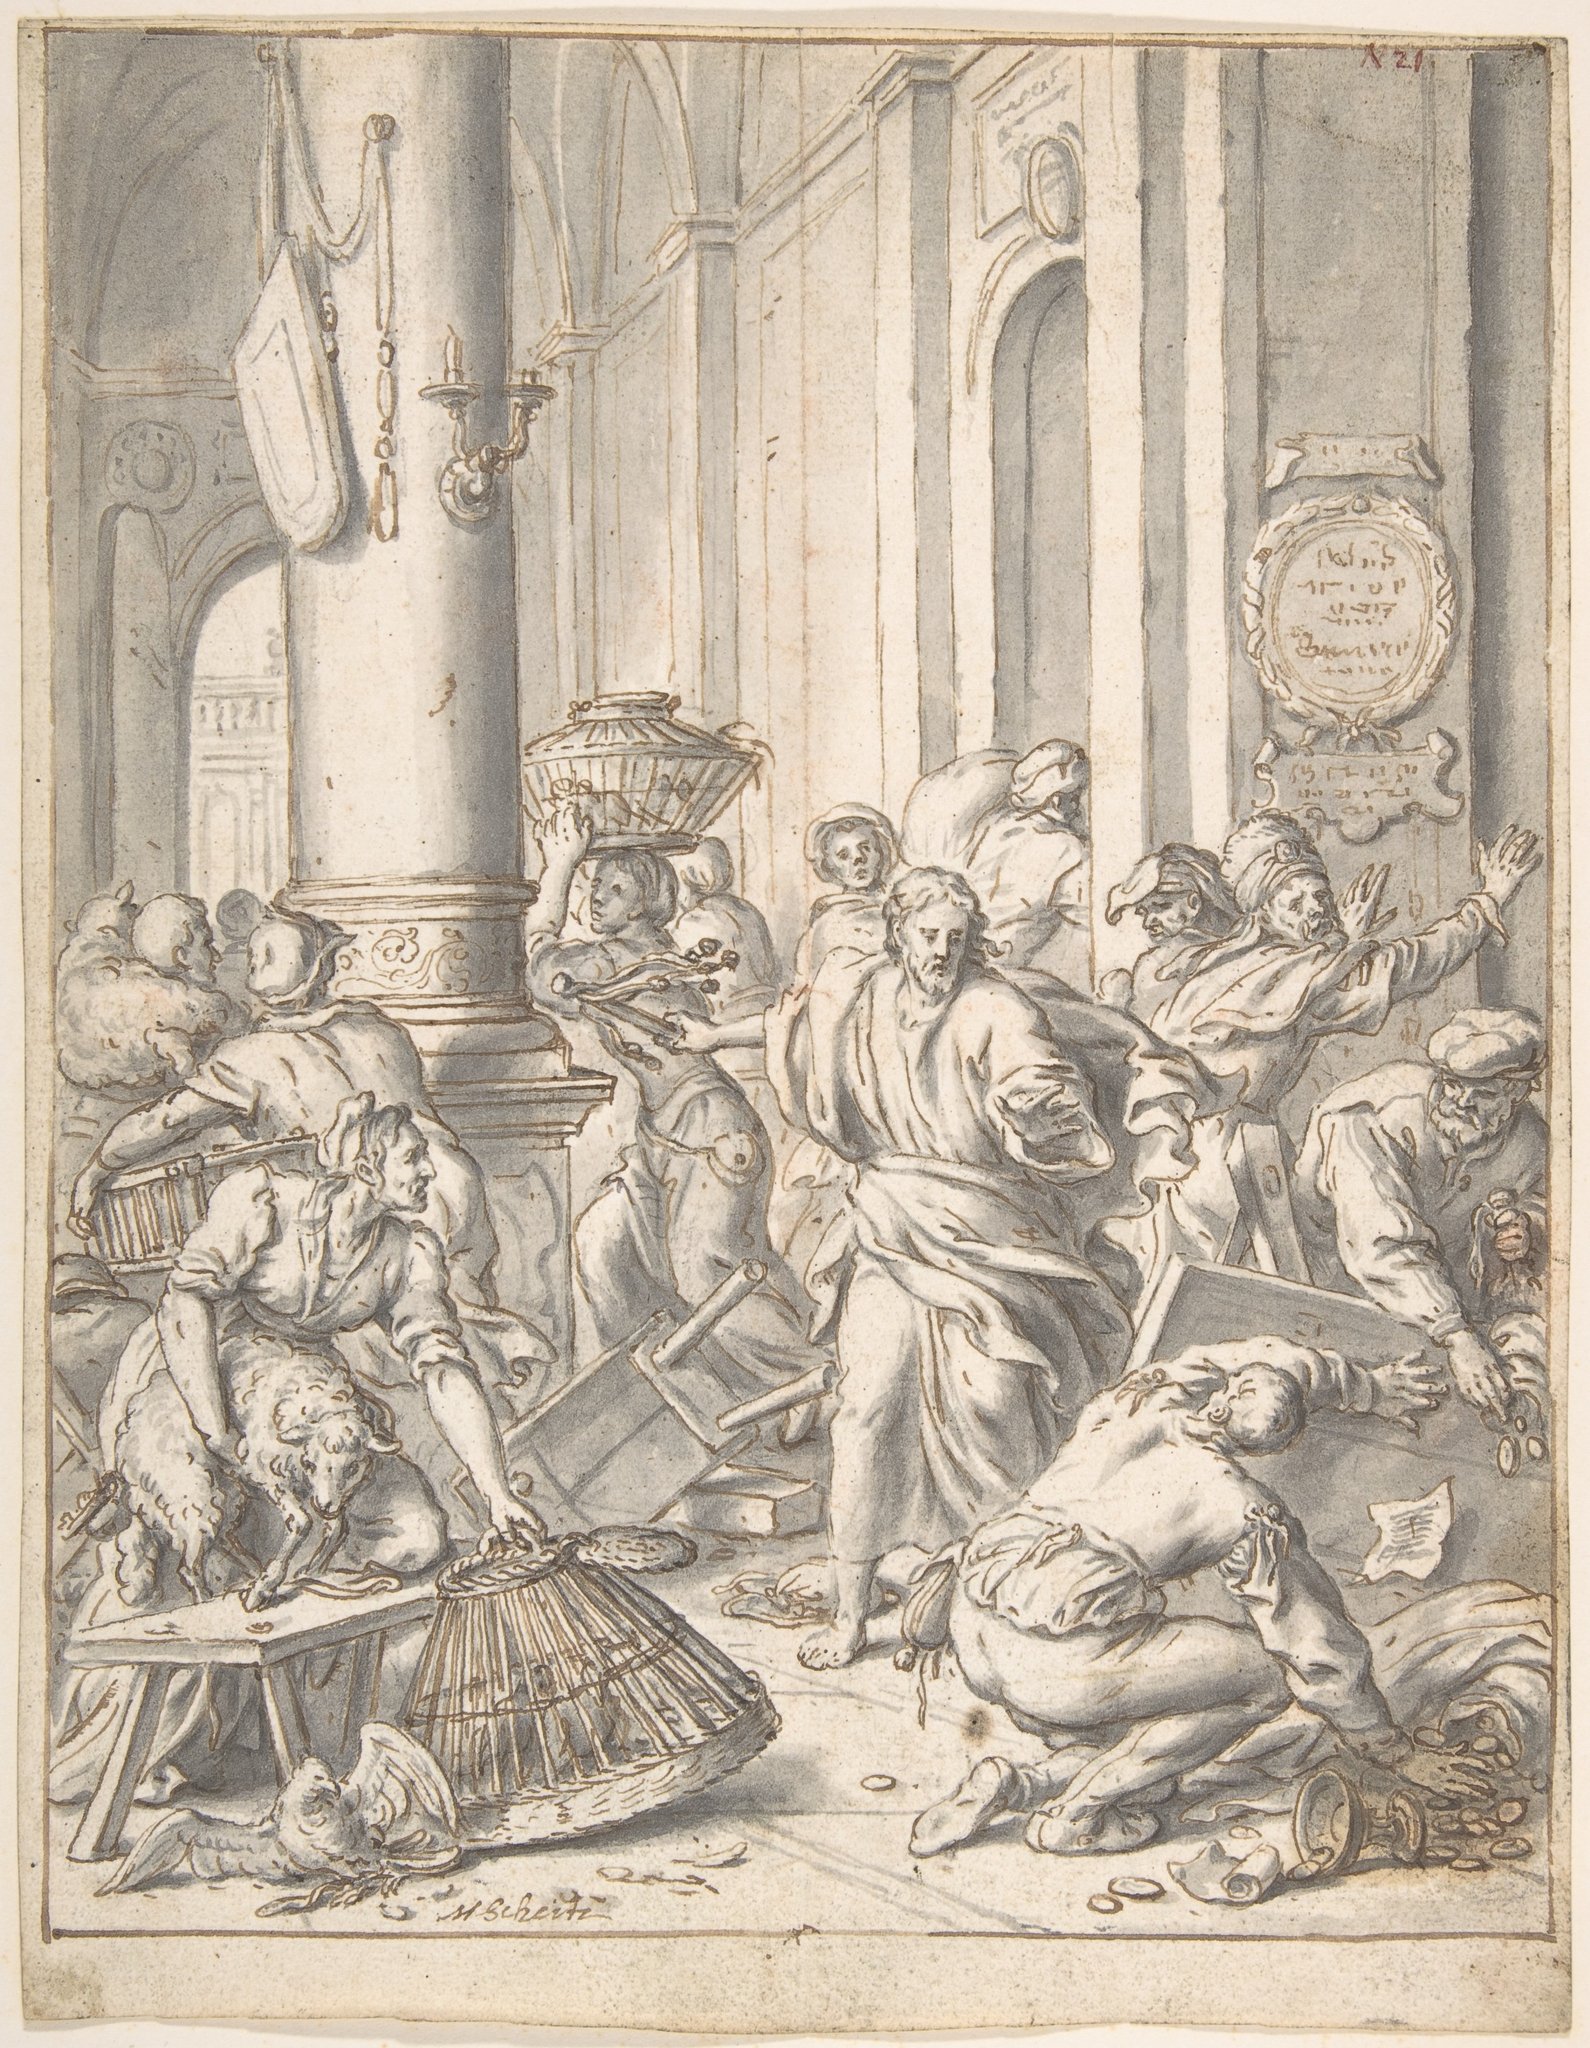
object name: drawing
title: Christ Driving the Money Changers from the Temple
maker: matthias scheits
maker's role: artist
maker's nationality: german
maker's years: 1625-1700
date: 1665-1670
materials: chalk, ink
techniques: incising, pen, transfer, wash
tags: birds,men,christ,coins